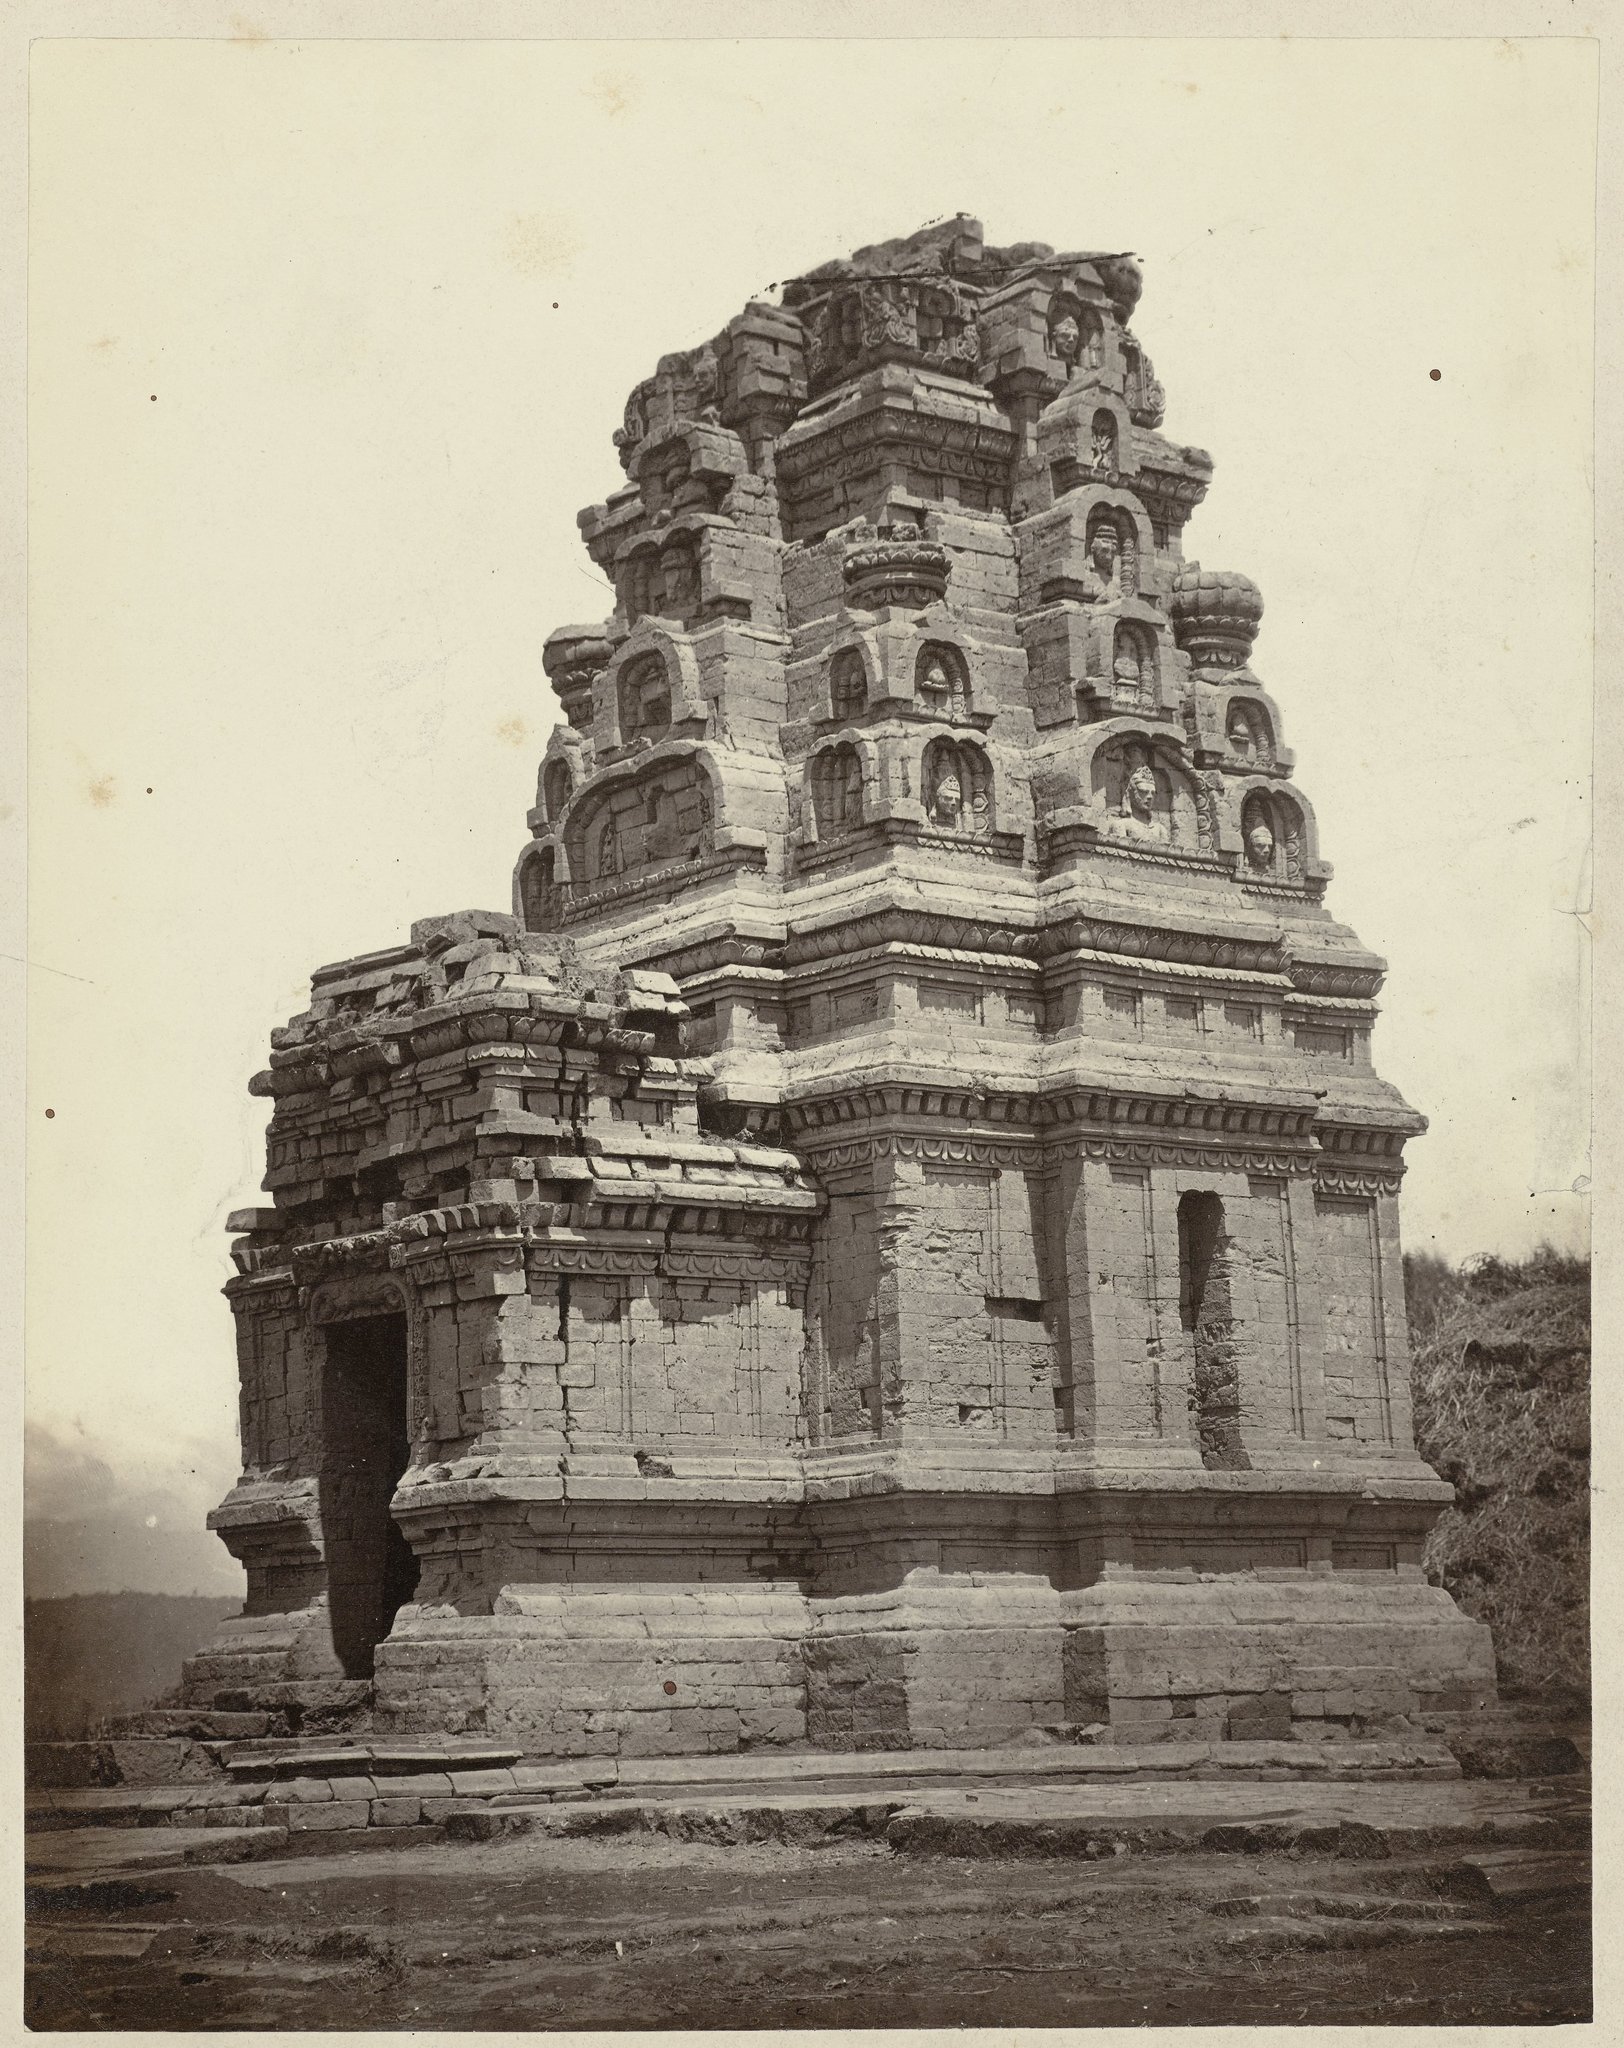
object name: photograph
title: Candi Bhima, general view including its superstructure with sculpted heads and entrance. Dieng plateau, Wonosobo district, Central Java province, 9th century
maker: isidore kinsbergen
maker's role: fotograaf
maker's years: 1821-1905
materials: cardboard, paper, photographic support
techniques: albumen print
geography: java